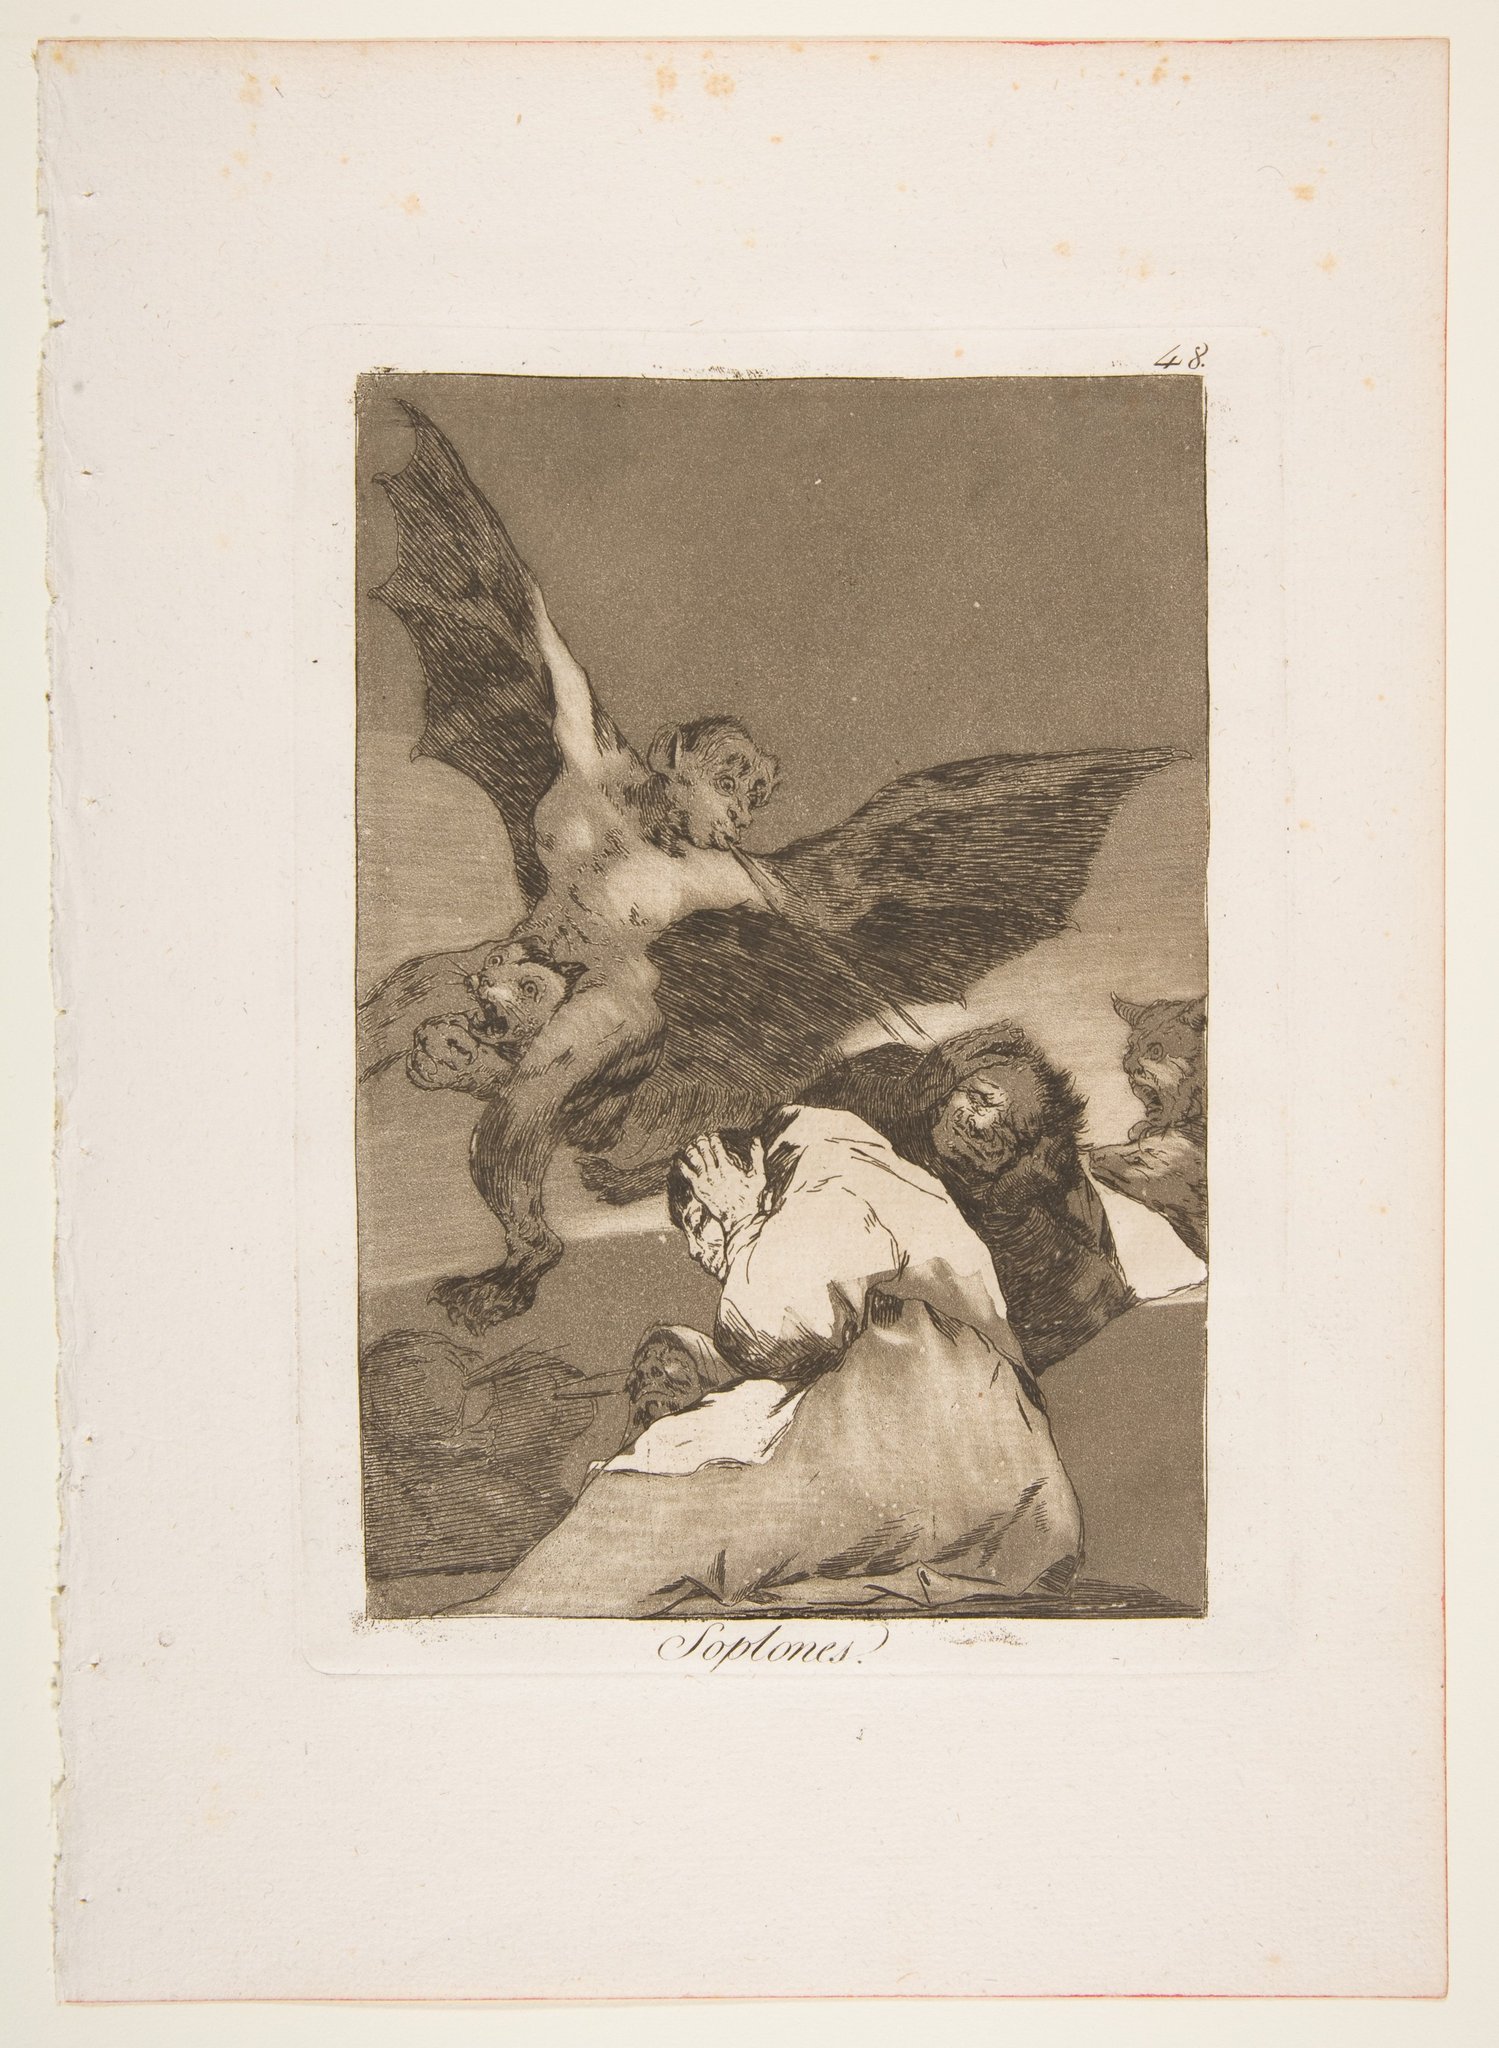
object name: print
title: Plate 48 from "Los Caprichos": Tale-Bearers--Blasts of Wind (Soplones)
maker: goya (francisco de goya y lucientes)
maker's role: artist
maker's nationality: spanish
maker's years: 1746-1828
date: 1799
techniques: aquatint, burnishing, etching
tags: mythical creatures